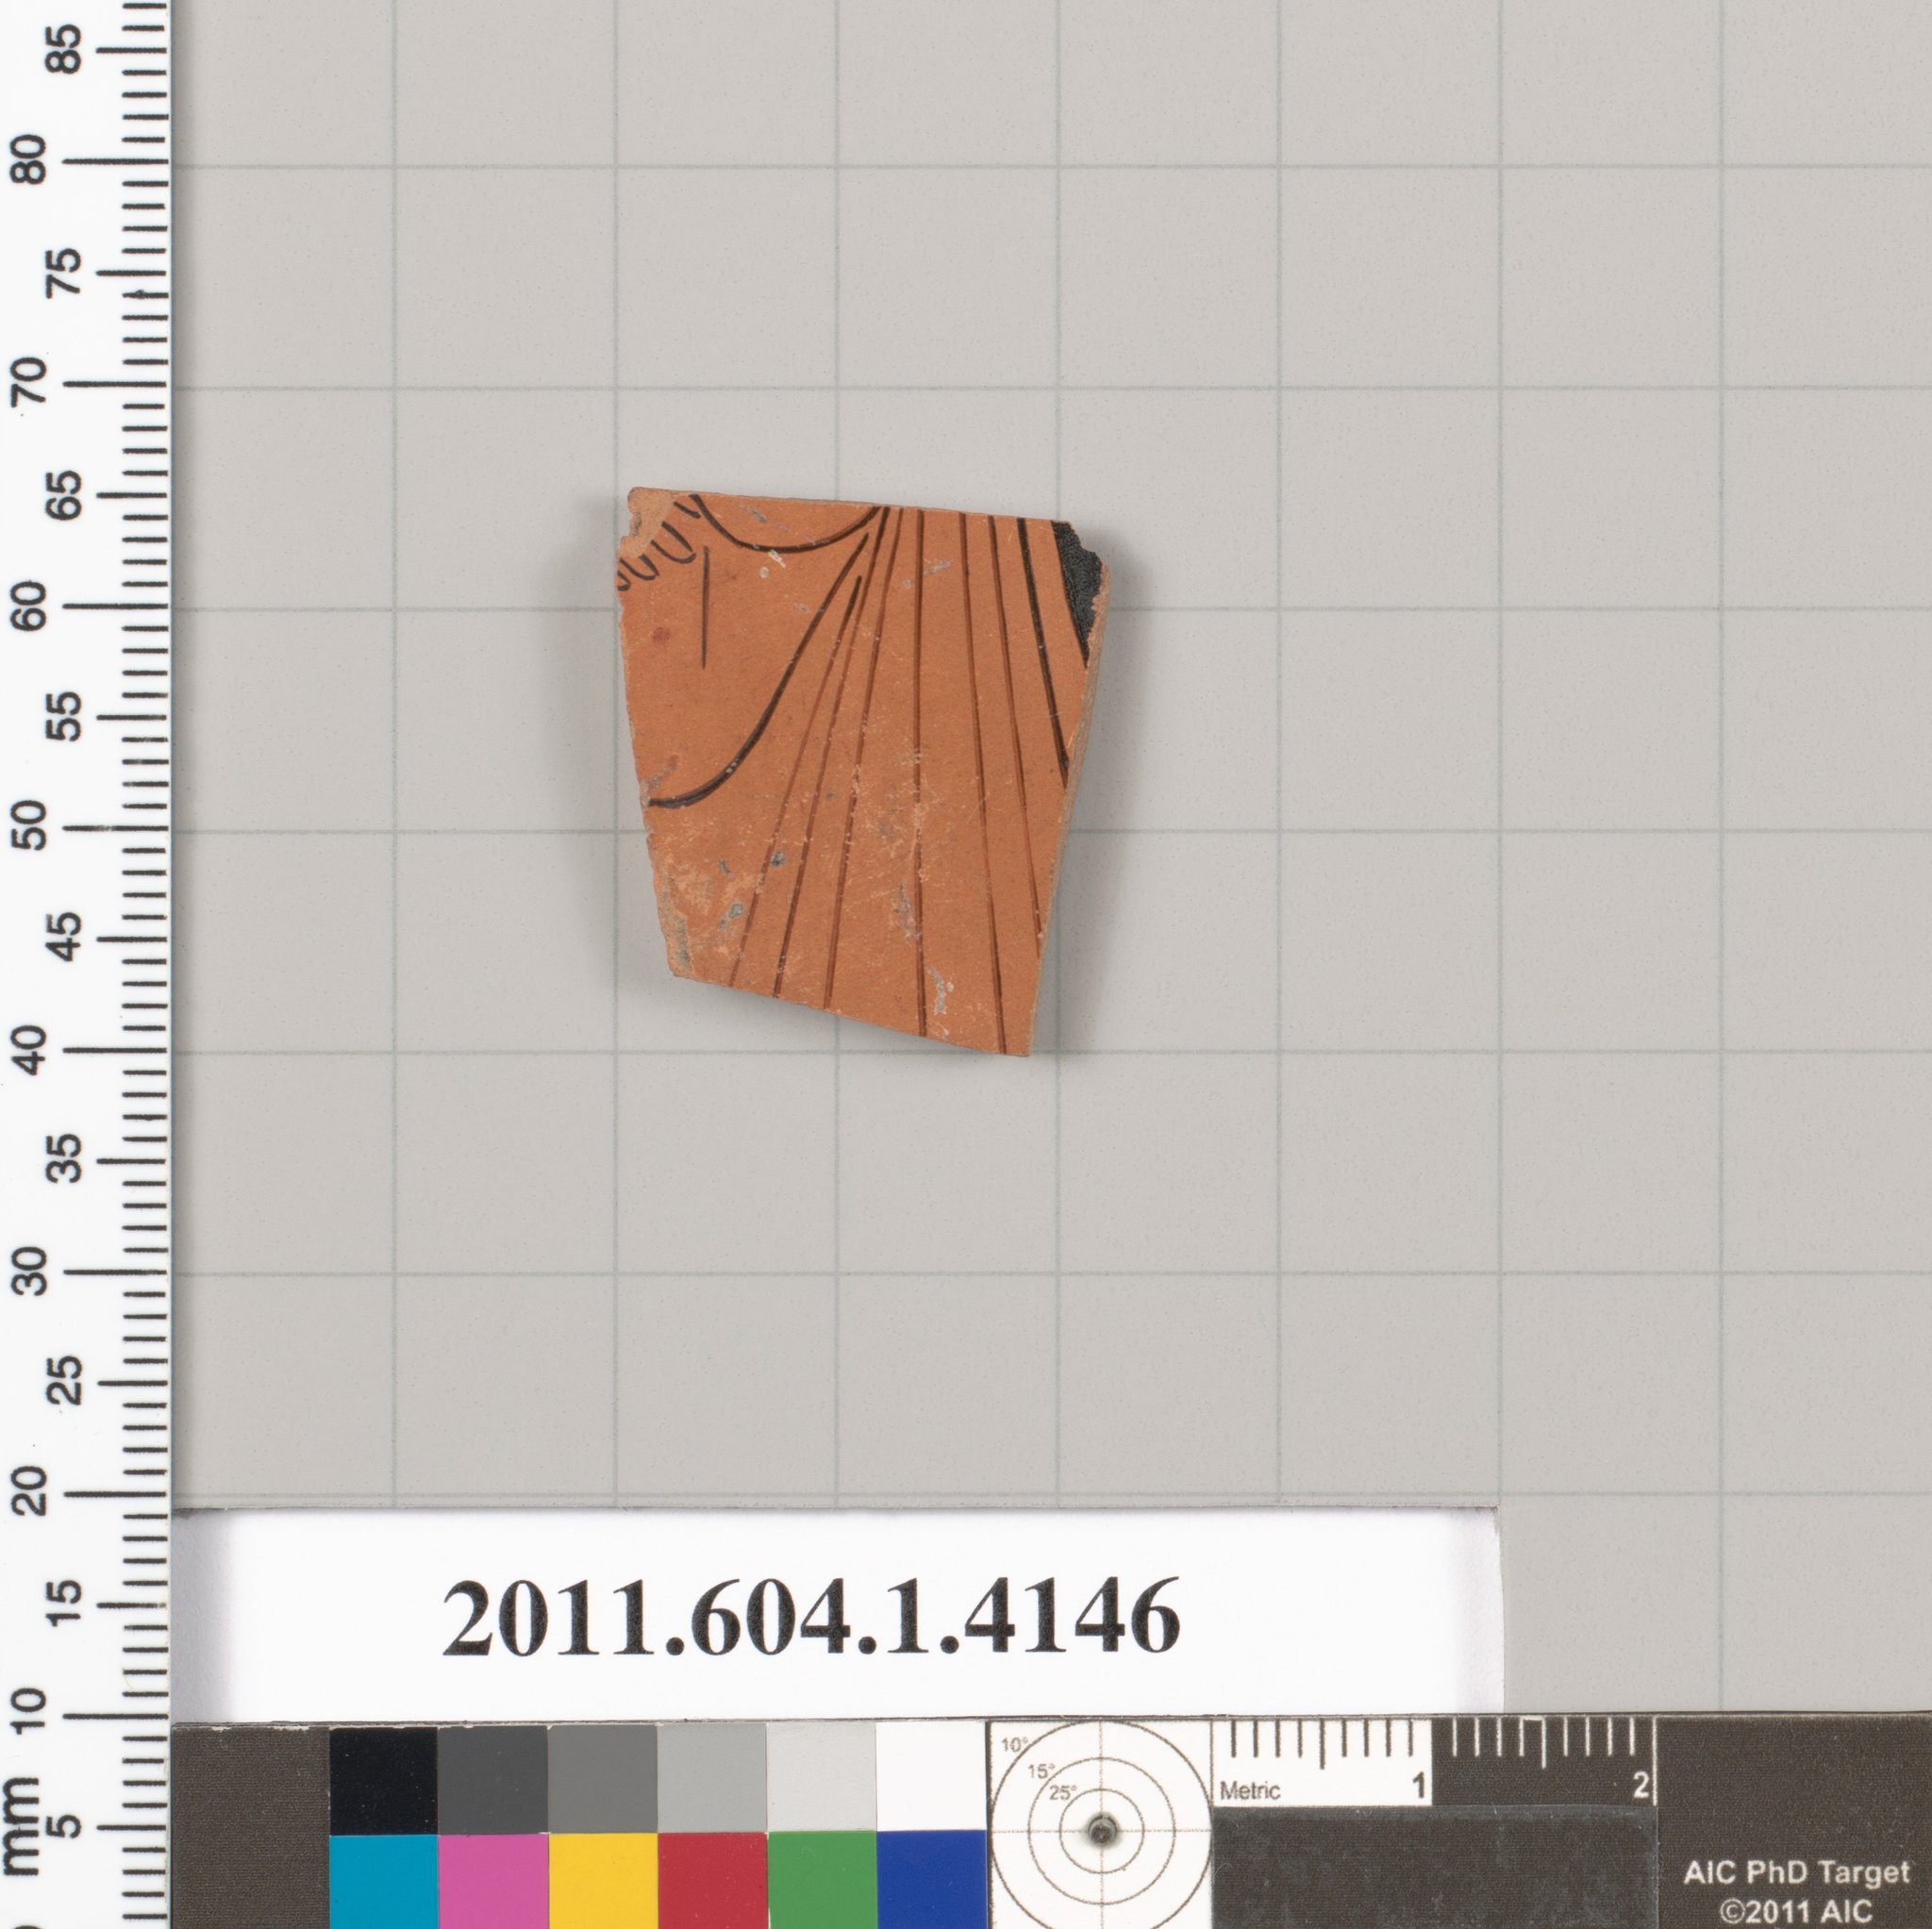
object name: kylix fragment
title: Terracotta fragment of a kylix (drinking cup)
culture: greek, attic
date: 490-470 BCE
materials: terracotta